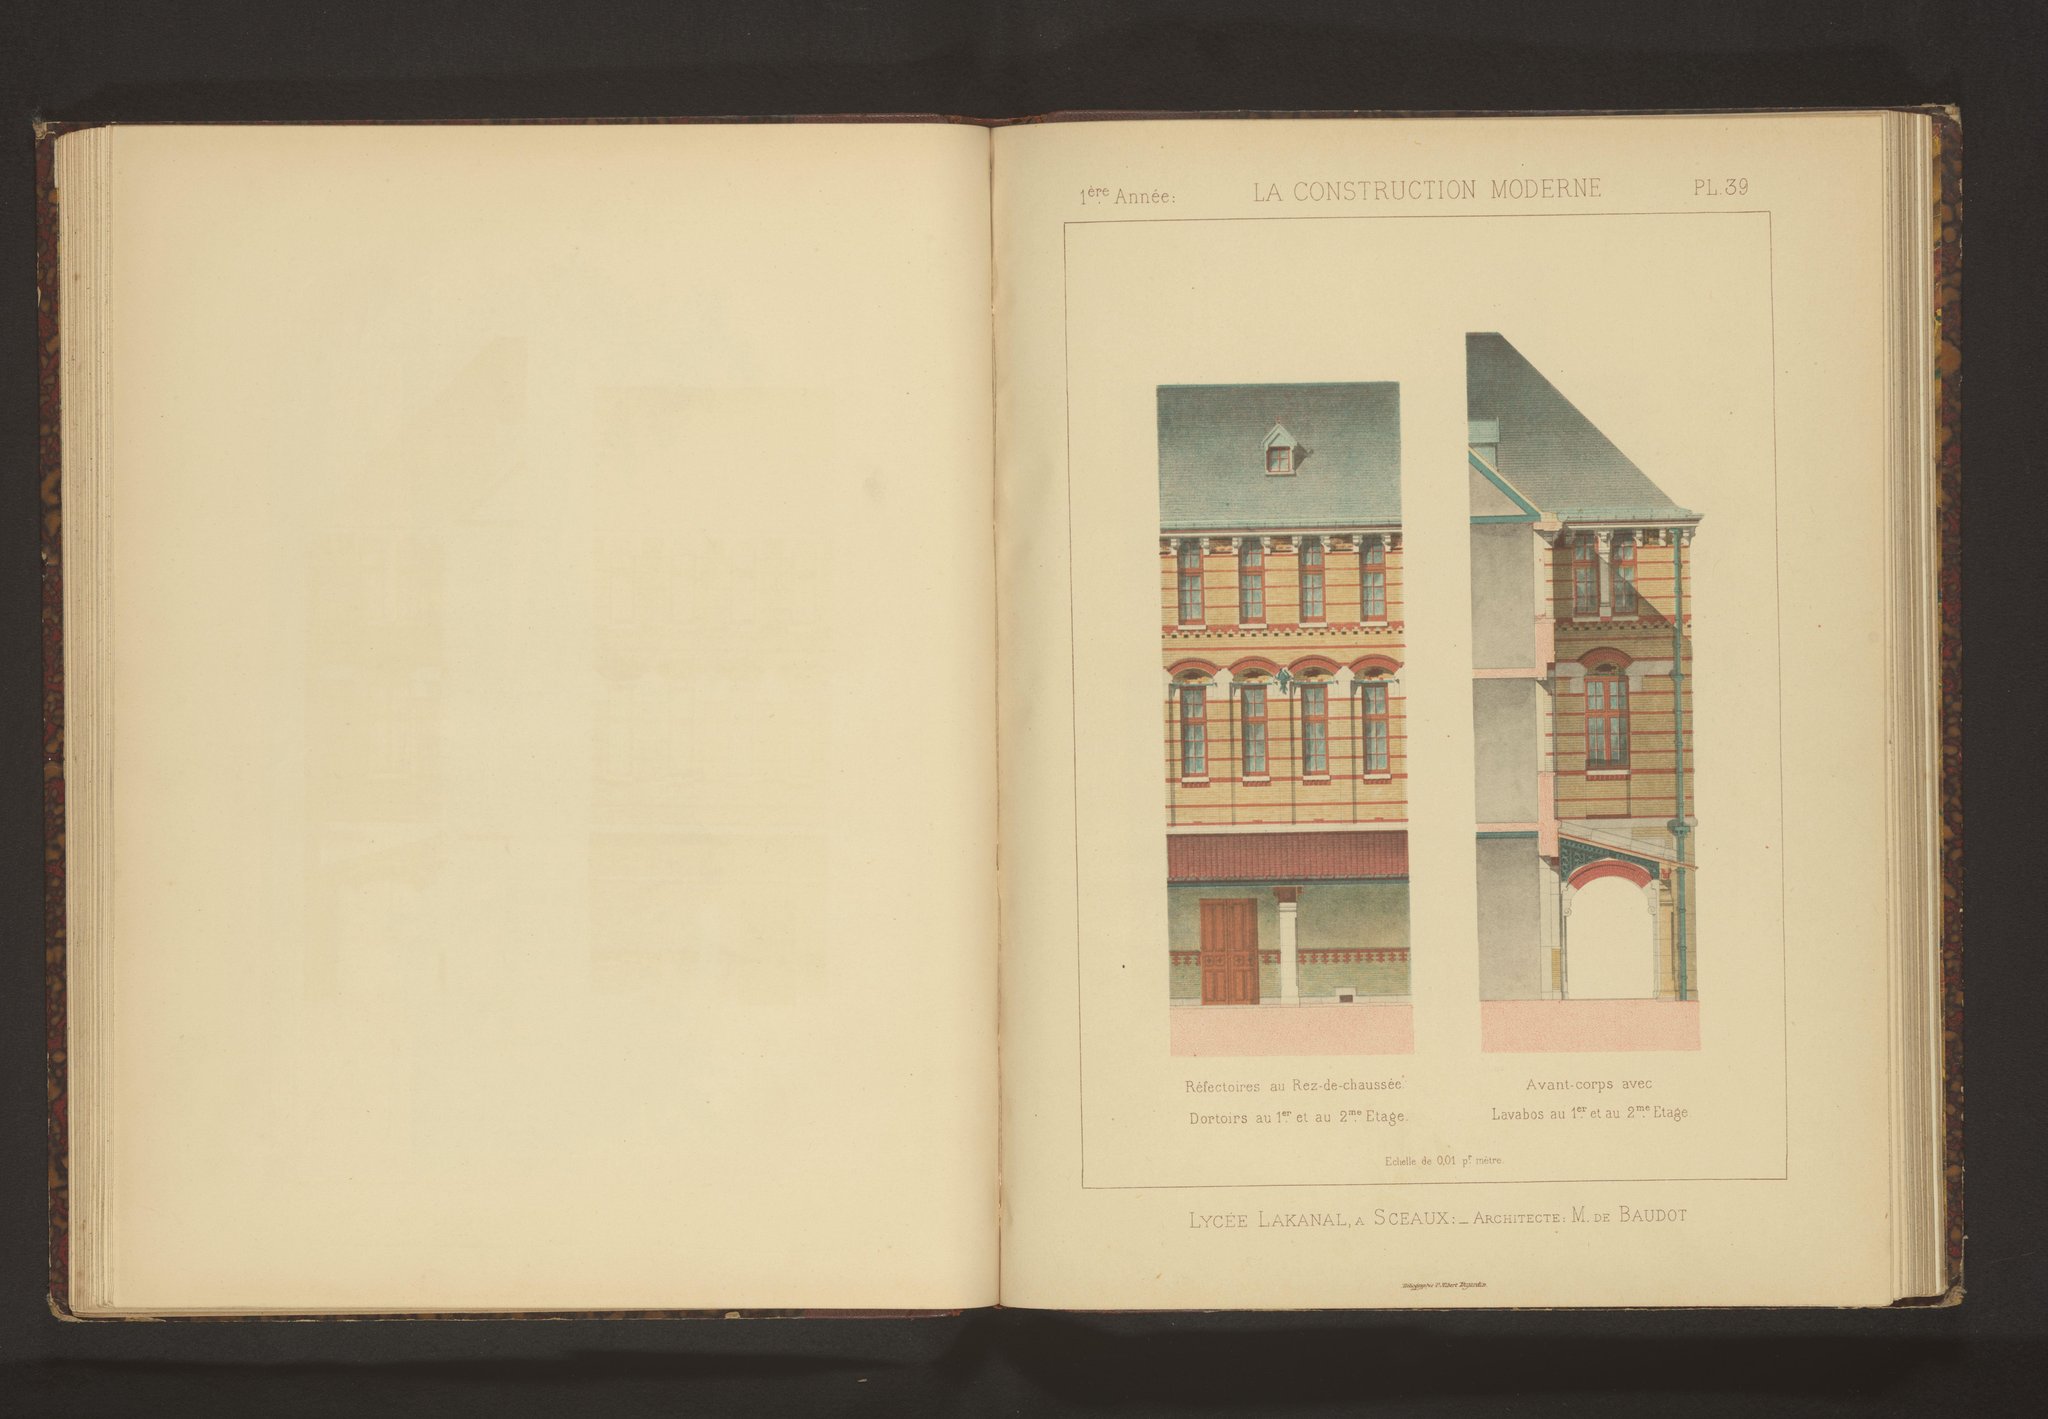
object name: page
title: Lycée Lakanal, a Sceaux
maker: paul dujardin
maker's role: print maker, printer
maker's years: 1843-1913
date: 1881-1886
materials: paper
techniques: photograph, lithograph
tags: secondary education, civic architecture; edifices; dwellings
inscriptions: inscription: ‘Avant-corps avec/ Lavabos au 1er et au 2me Etage’, inscription: ‘Echelle de 0,01 pr mètre.’, inscription: ‘Architecte: M. de Baudot’, inscription: ‘Réfectoires au Rez-de-chausée./ Dortoirs au 1er et 2me Etage.’, inscription: ‘1ère Année: LA CONSTRUCTION MODERNE Pl. 39’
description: Links een deel van een vooraanzicht, rechts een deel van een zijaanzicht.